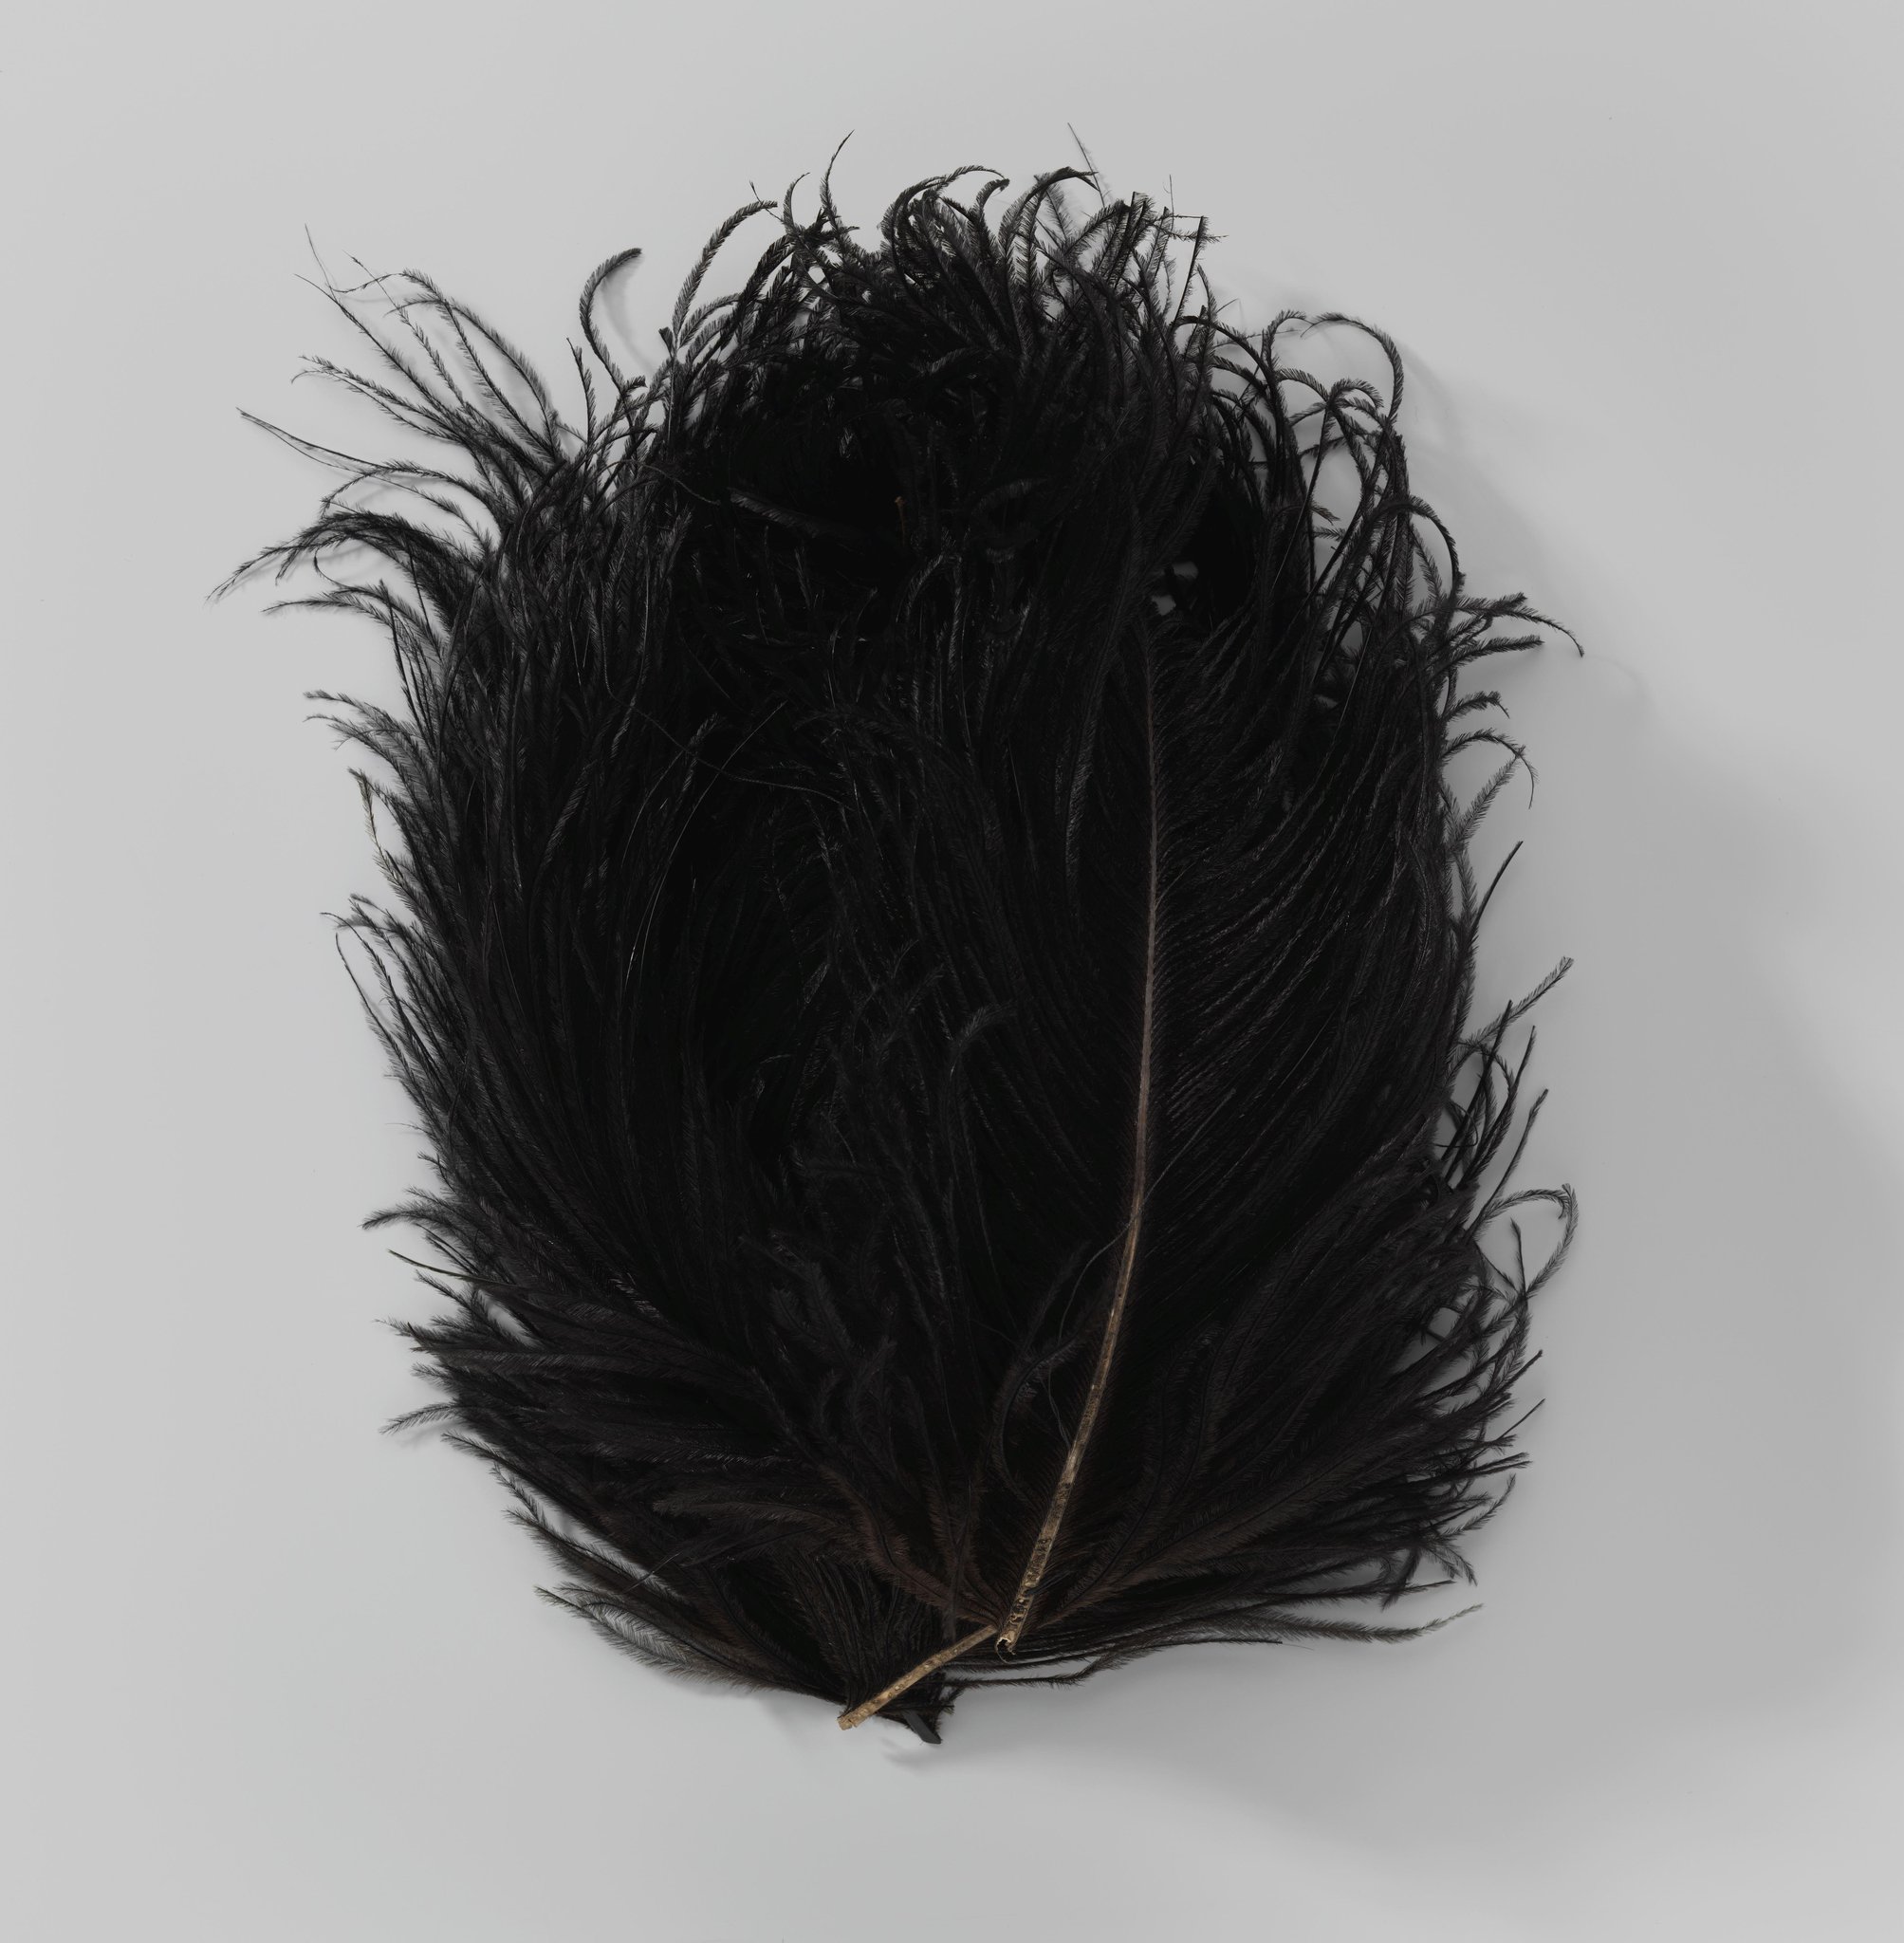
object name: womenswear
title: Toef struisveren, zwart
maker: Anonymous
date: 1880-1925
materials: ostrich feather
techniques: painting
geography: western europe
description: Toef struisveren, zwart. De veren zijn van elkaar los geraakt.